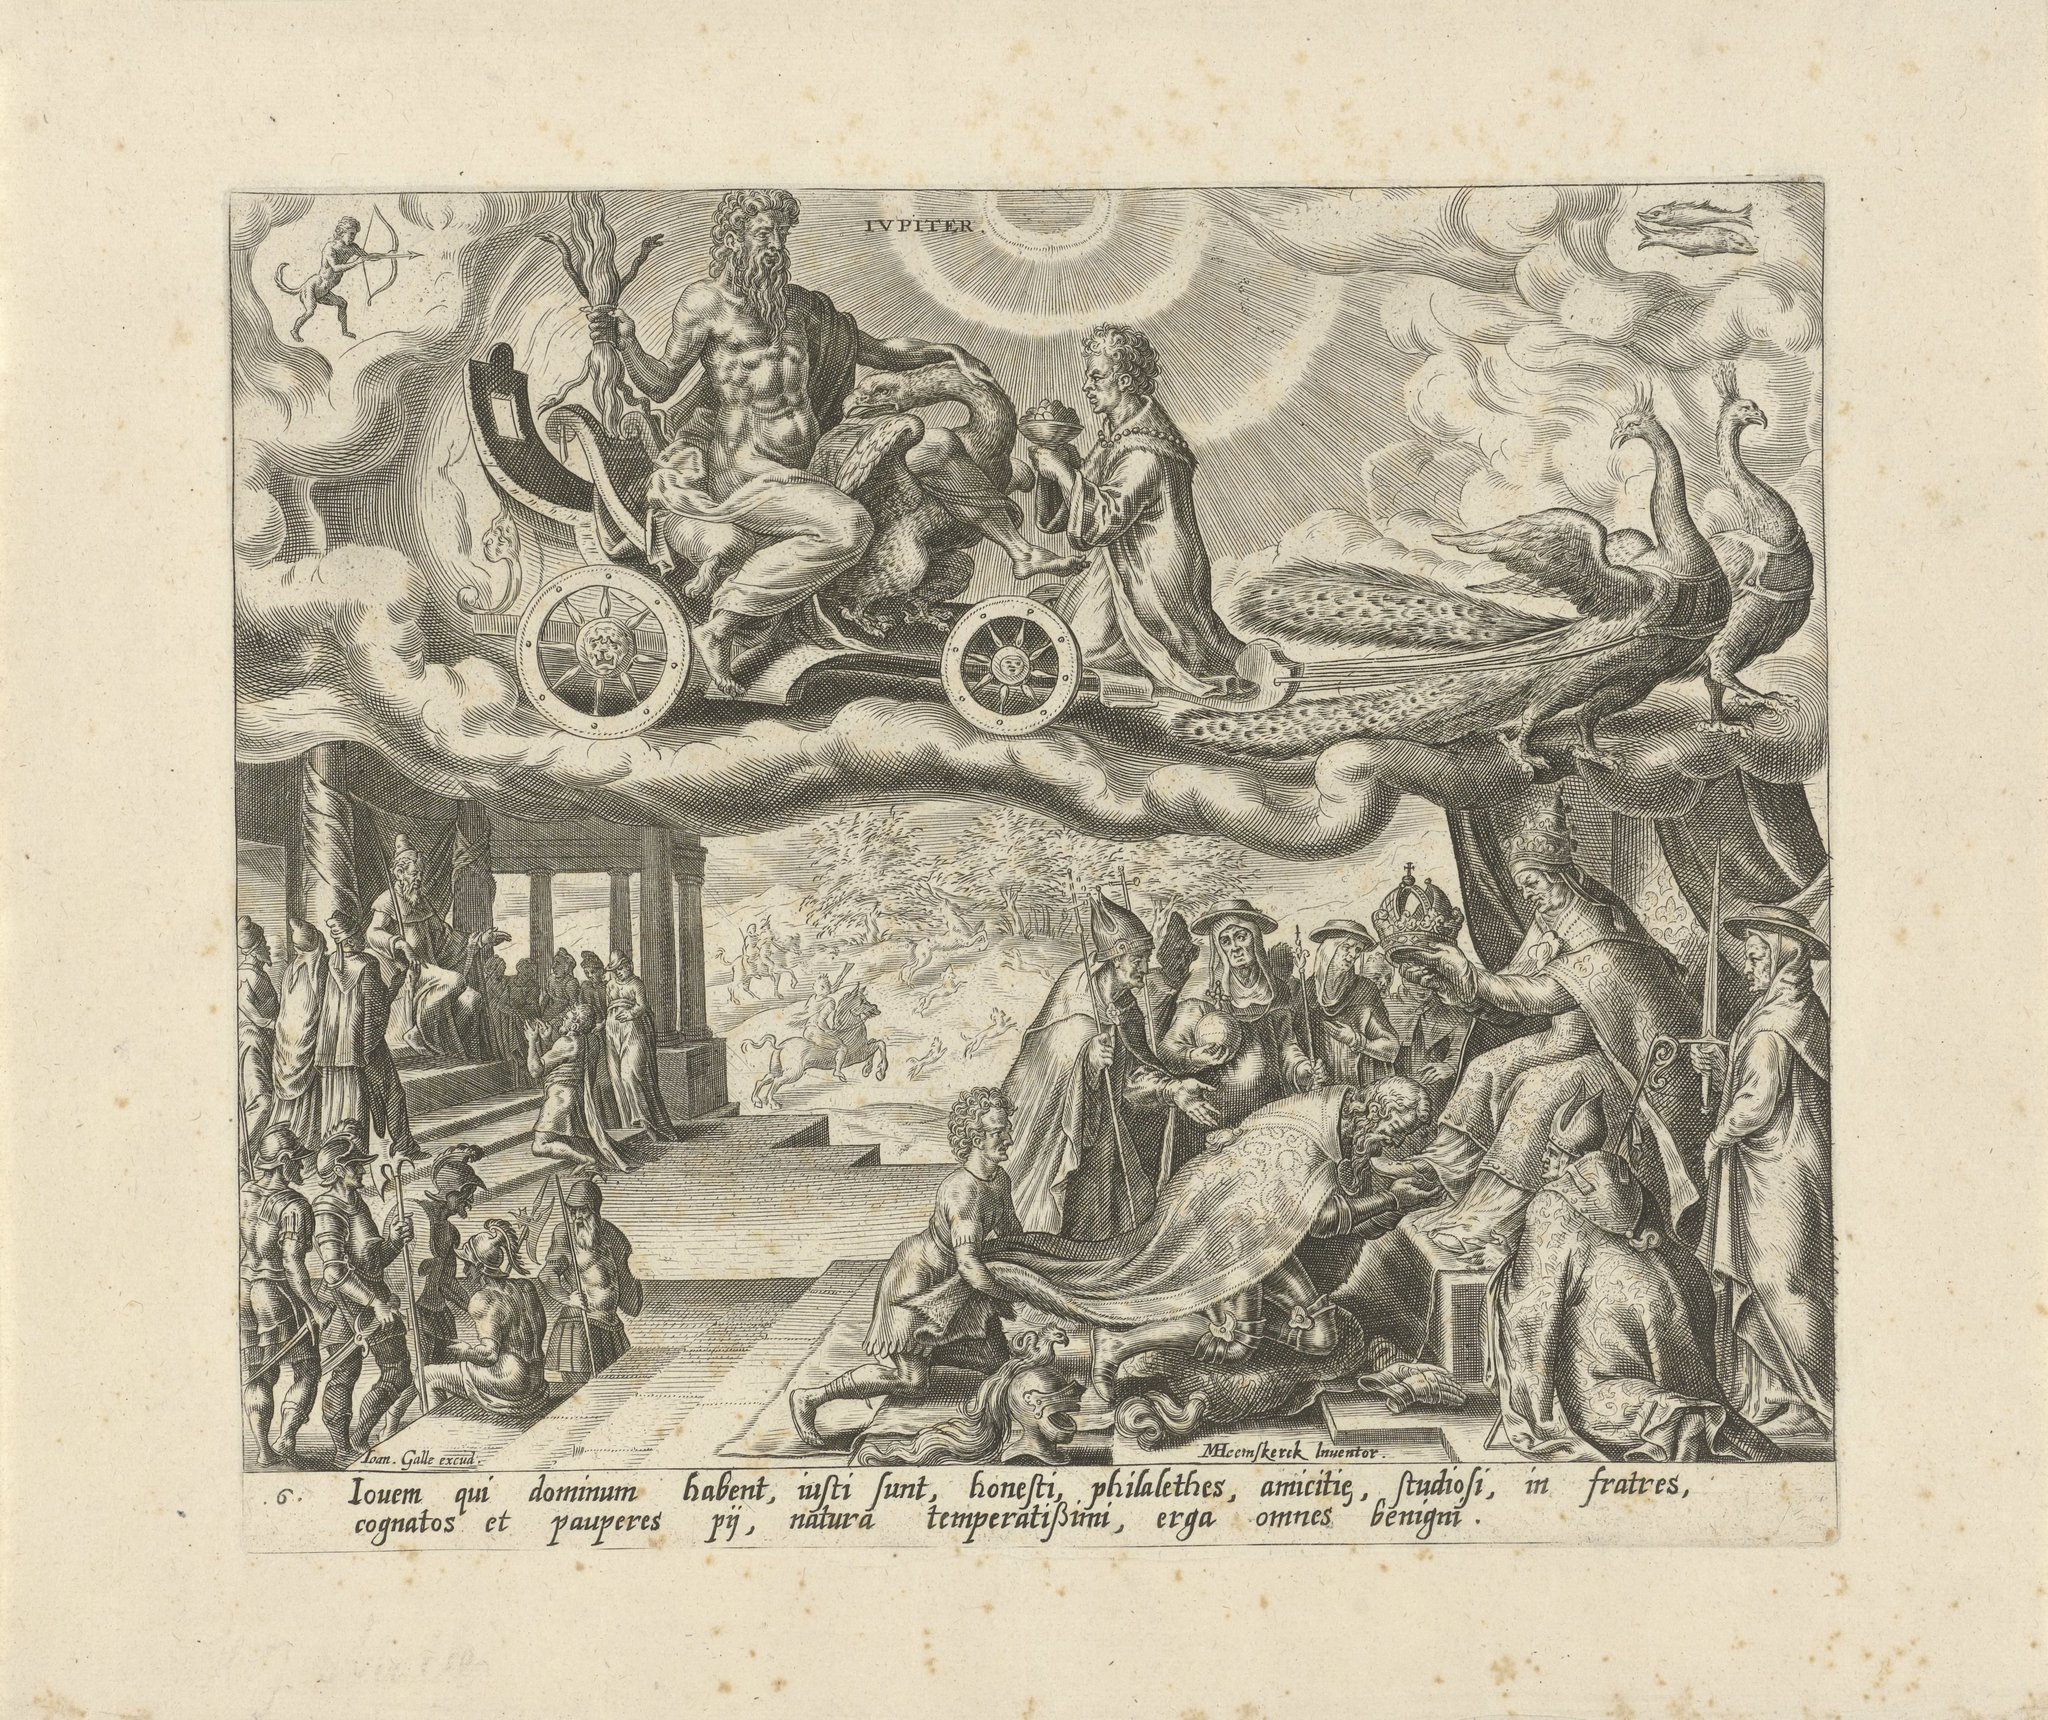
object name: print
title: De planeet Jupiter en zijn kinderen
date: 1566-1570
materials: paper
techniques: engraving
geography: antwerp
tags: hunting, chase, jupiter and his children ('planetenkinder') ~ pisces and sagittarius, ornamental birds: peacock, magistracy, judges, pope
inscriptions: collector's mark: Lugt 2228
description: Prent mogelijk gebruikt in: Speculum diversarum imaginum speculativarum a variis doctis adinventarum, atque ab insignibus pictoribus ac sculptoribus delineatarum. Antwerpen: Johannes Galle, 1638. Of in: Schabaelje, Jan Philipsz. Den grooten figver-bibel. Dat is een afbeeldingh en levendighe vertooningh, van alle de voornaemste historien (...) der gantscher Heyliger Schrift, in schoone copere figueren (...) verrijckt met leersame verclaeringhen over de selve figueren. Alkmaar: Simon Cornelisz Brekegeest, Amsterdam: Jan Philipsz. Schabaelje, 1646.